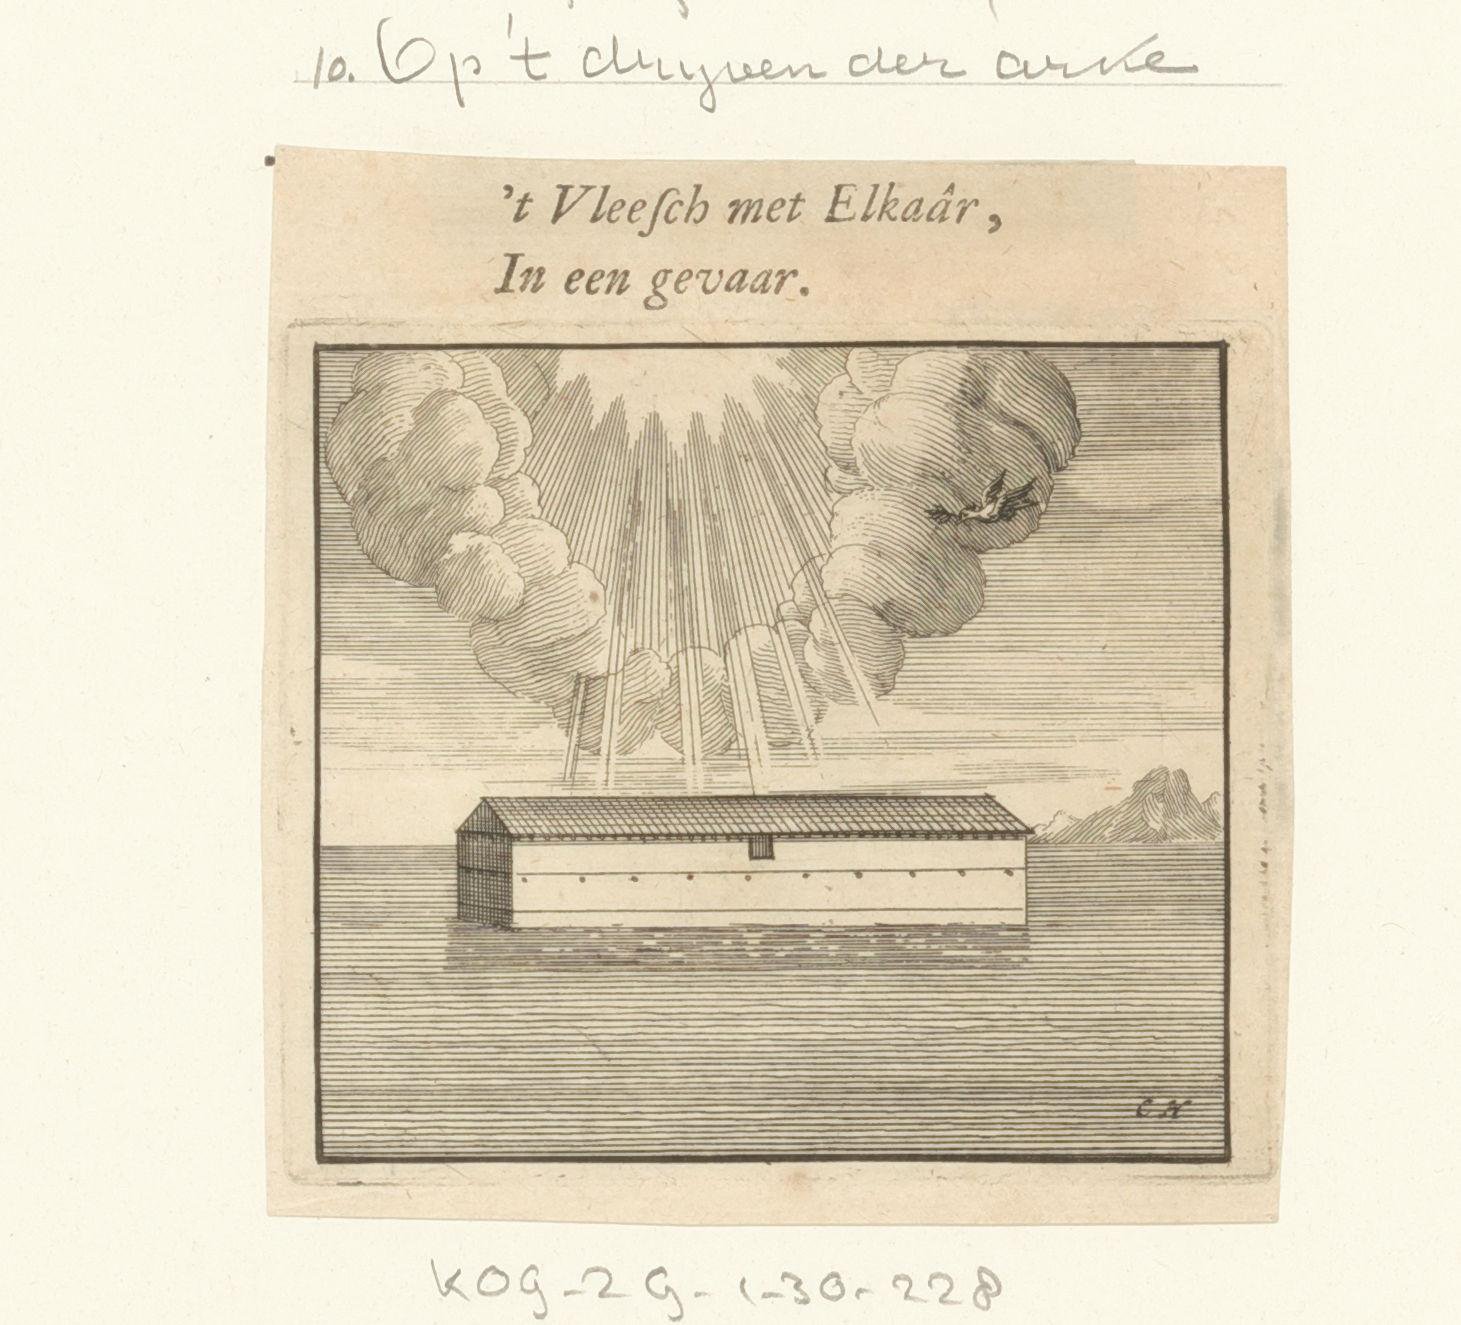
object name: print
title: 't Vleesch met Elkaar, In een gevaar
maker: cornelis huyberts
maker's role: print maker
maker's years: 1669-1709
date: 1725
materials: paper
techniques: etching, letterpress printing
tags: story of noah, the ark is floating on the waters, while life on earth is destroyed ~ story of noah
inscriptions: collector's mark: Lugt 1641, stamp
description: Prent uit: Graauwhart, Hendrik. Voorbeeldelyke zeede-lessen, genoomen uyt den eersten toestand des werelds (...). Amsterdam: Johannes Ratelband, 1725. Prent ook gebruikt voor eerdere en (1709) latere uitgave (1756, 1761 en 1764).